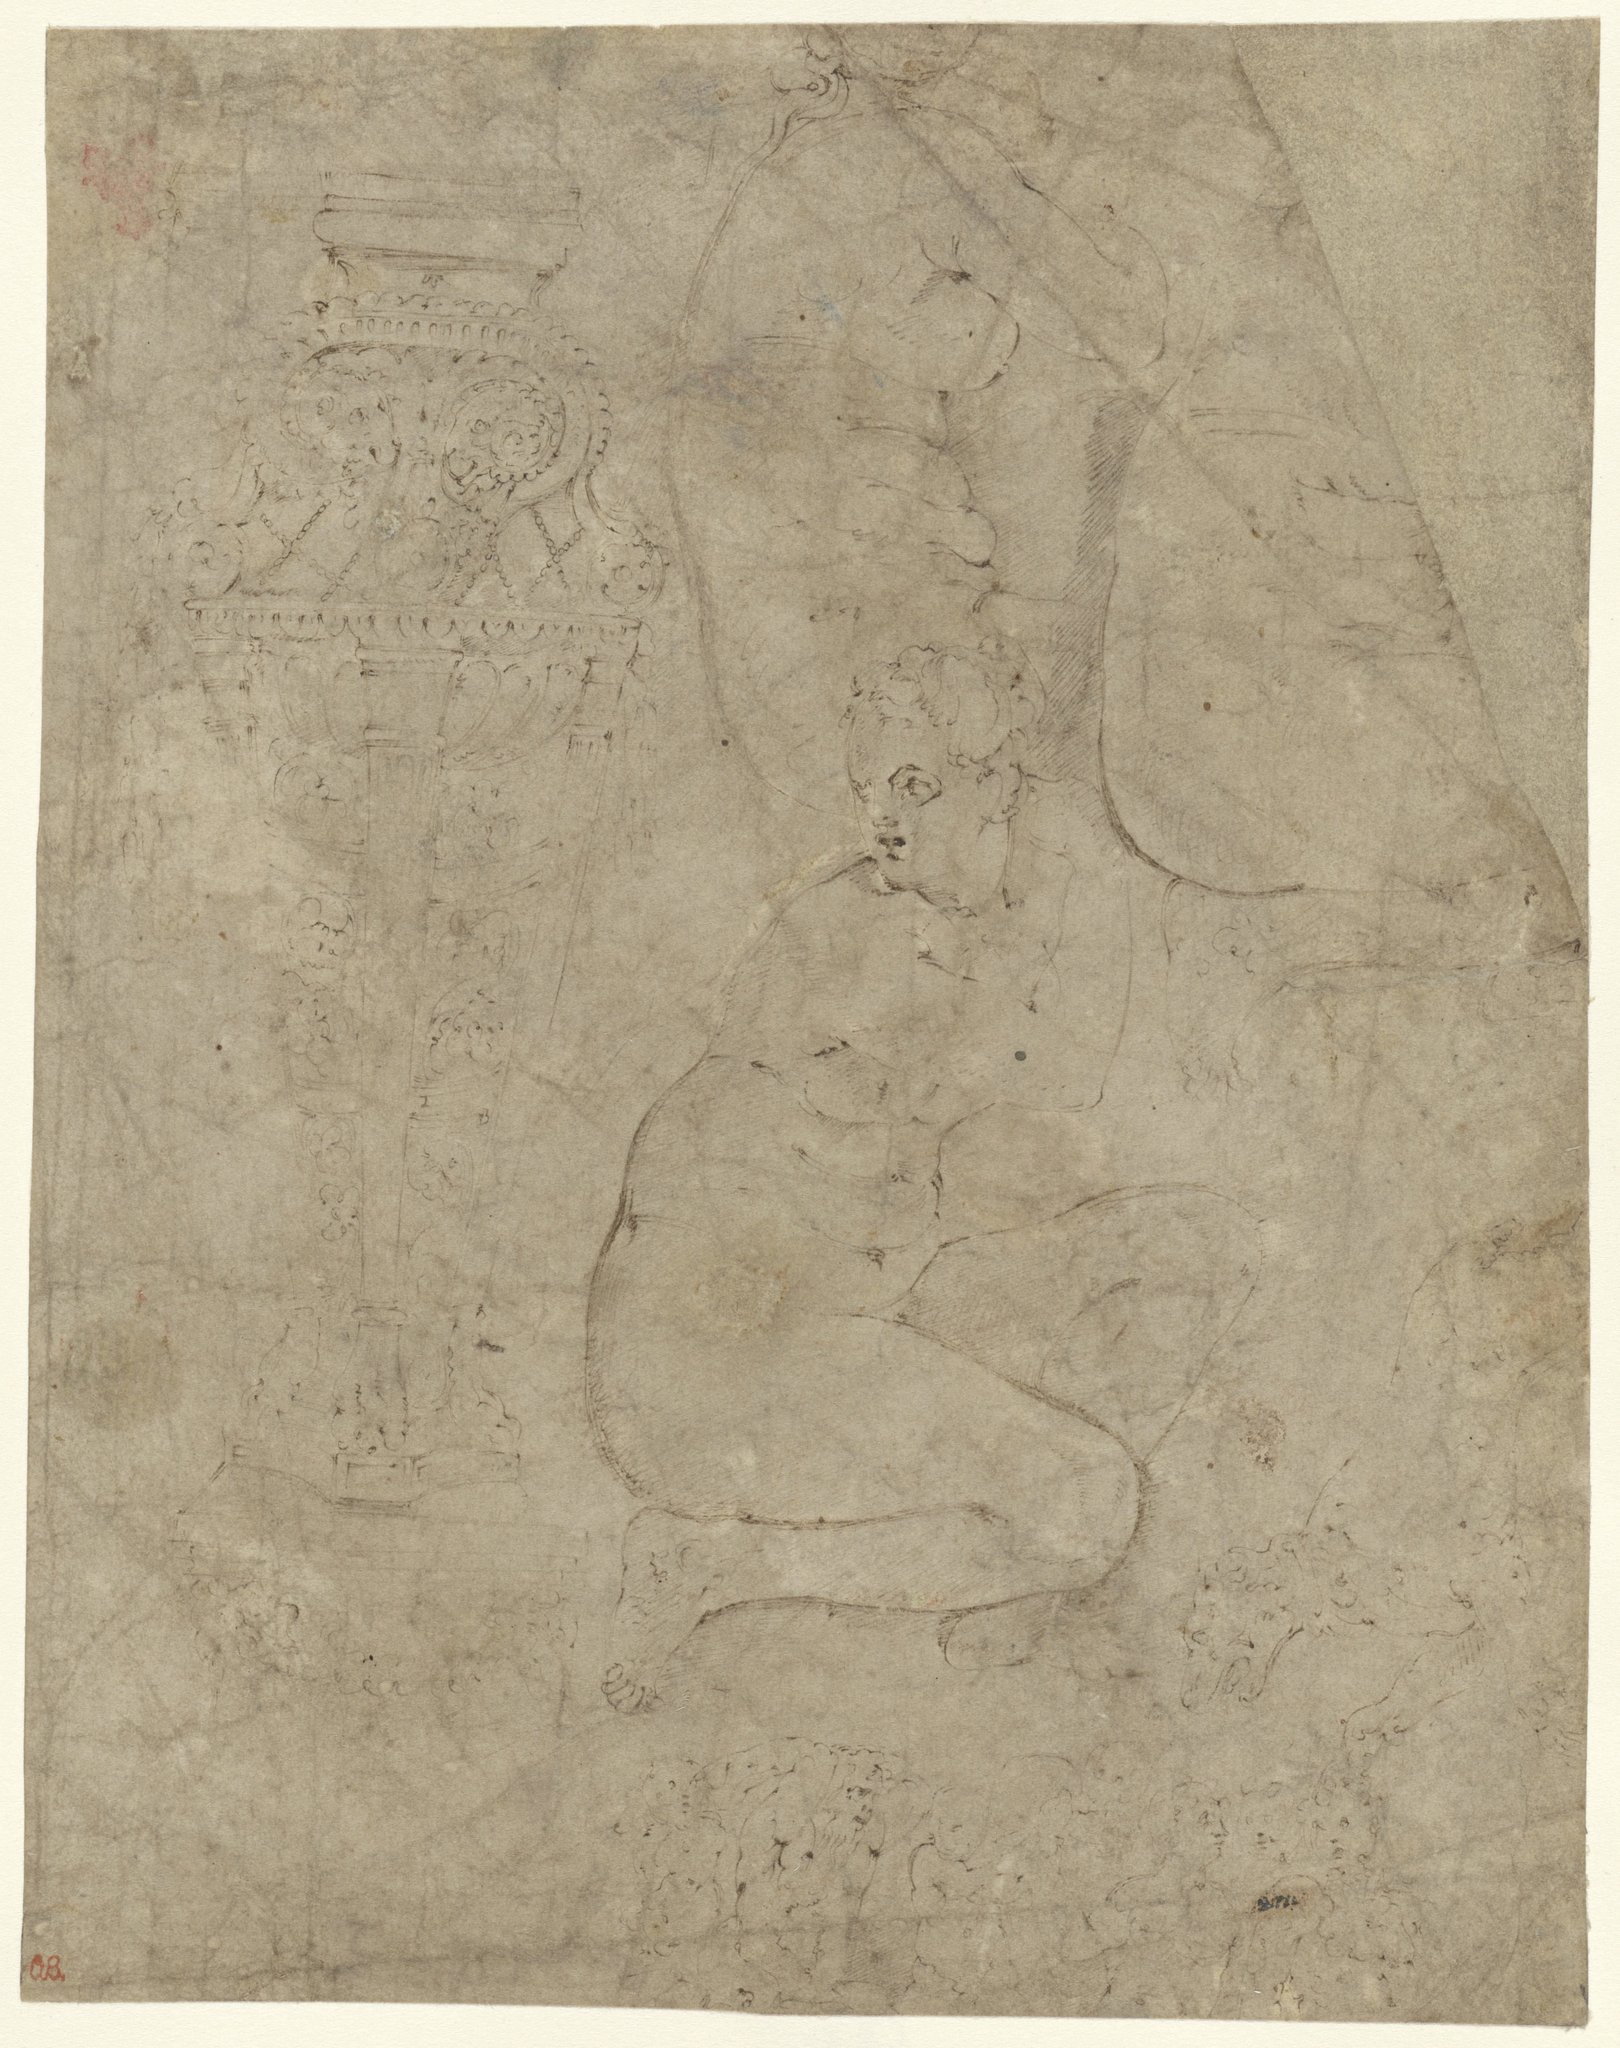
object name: drawing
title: Drie schetsen van een naakte vrouw, een pilaster en enkele andere kleine figuren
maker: Anonymous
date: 1480-1600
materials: ink, paper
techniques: pen